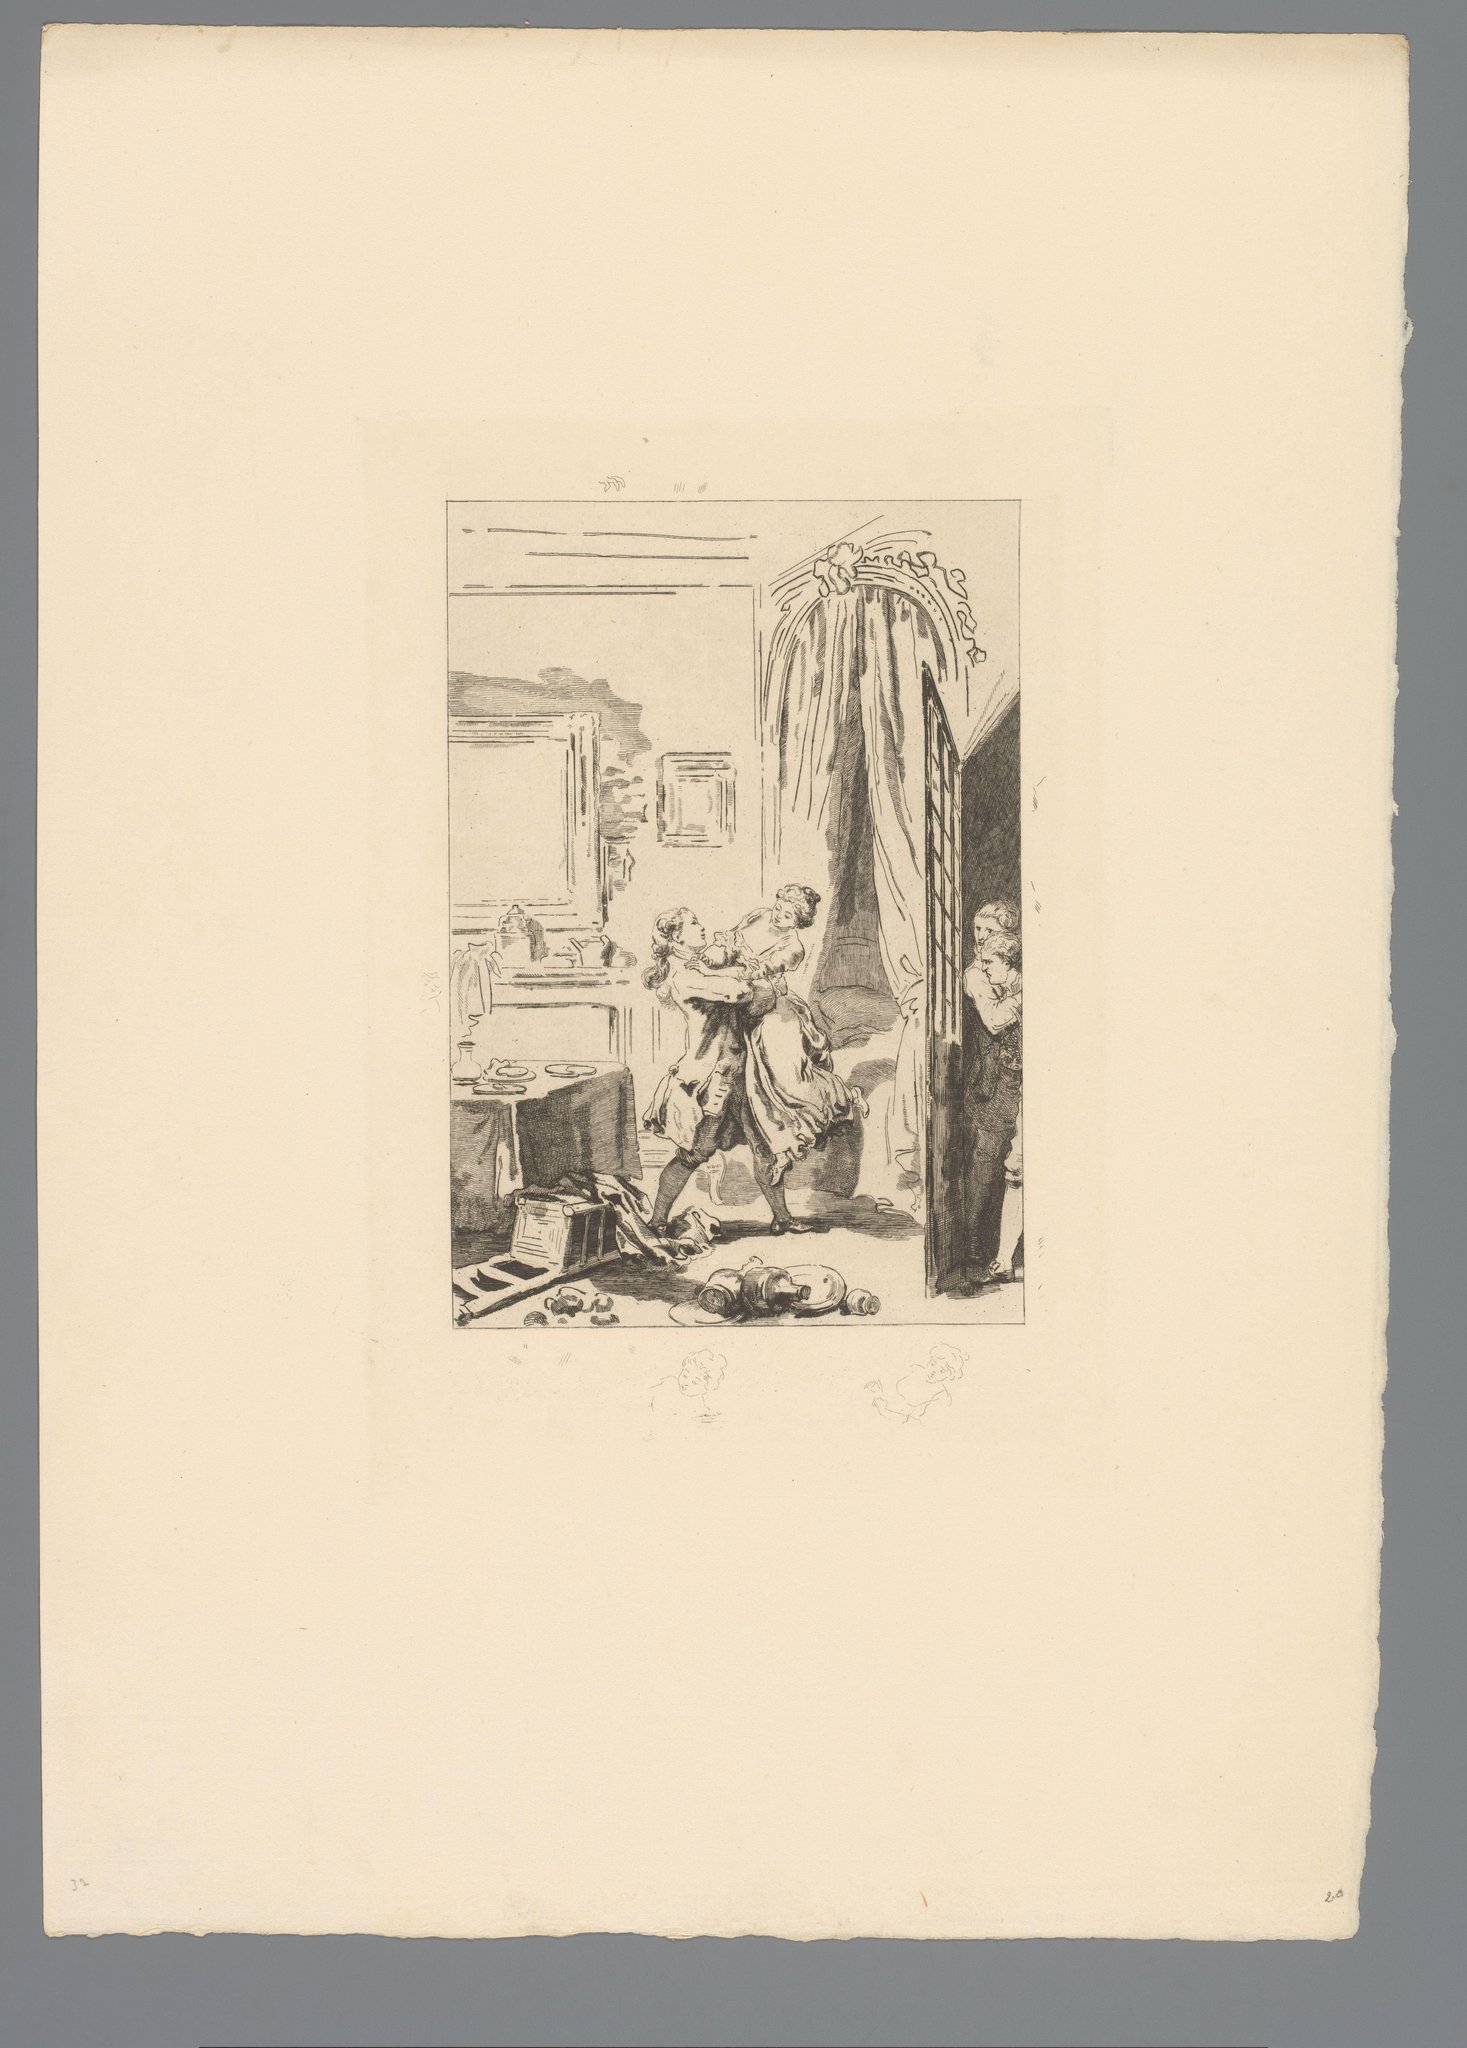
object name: photomechanical print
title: Reproductie van een prent naar een tekening van een man die probeert een vrouw te omhelzen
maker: Anonymous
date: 1880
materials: paper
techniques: photoaquatint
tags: one-sided courting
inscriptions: collector's mark: Lugt 2228, collector's mark:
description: Martial Potémont maakte etsen naar de tekeningen van Fragonard, die zich bevonden in een manuscript in de collectie van de verzamelaar Eugène Paillet. Rouquette bood hem aan de tekeningen zo exact mogelijk in prent te laten brengen door Martial Potémont: dit resulteerde in een serie van 57 etsen. Vervolgens werden deze gereproduceerd door middel van heliogravure. Deze omslag betreft een editie voor de letter, "Eau forte pure", de 1e staat van 3 waar men uit kon kiezen bij deze serie.